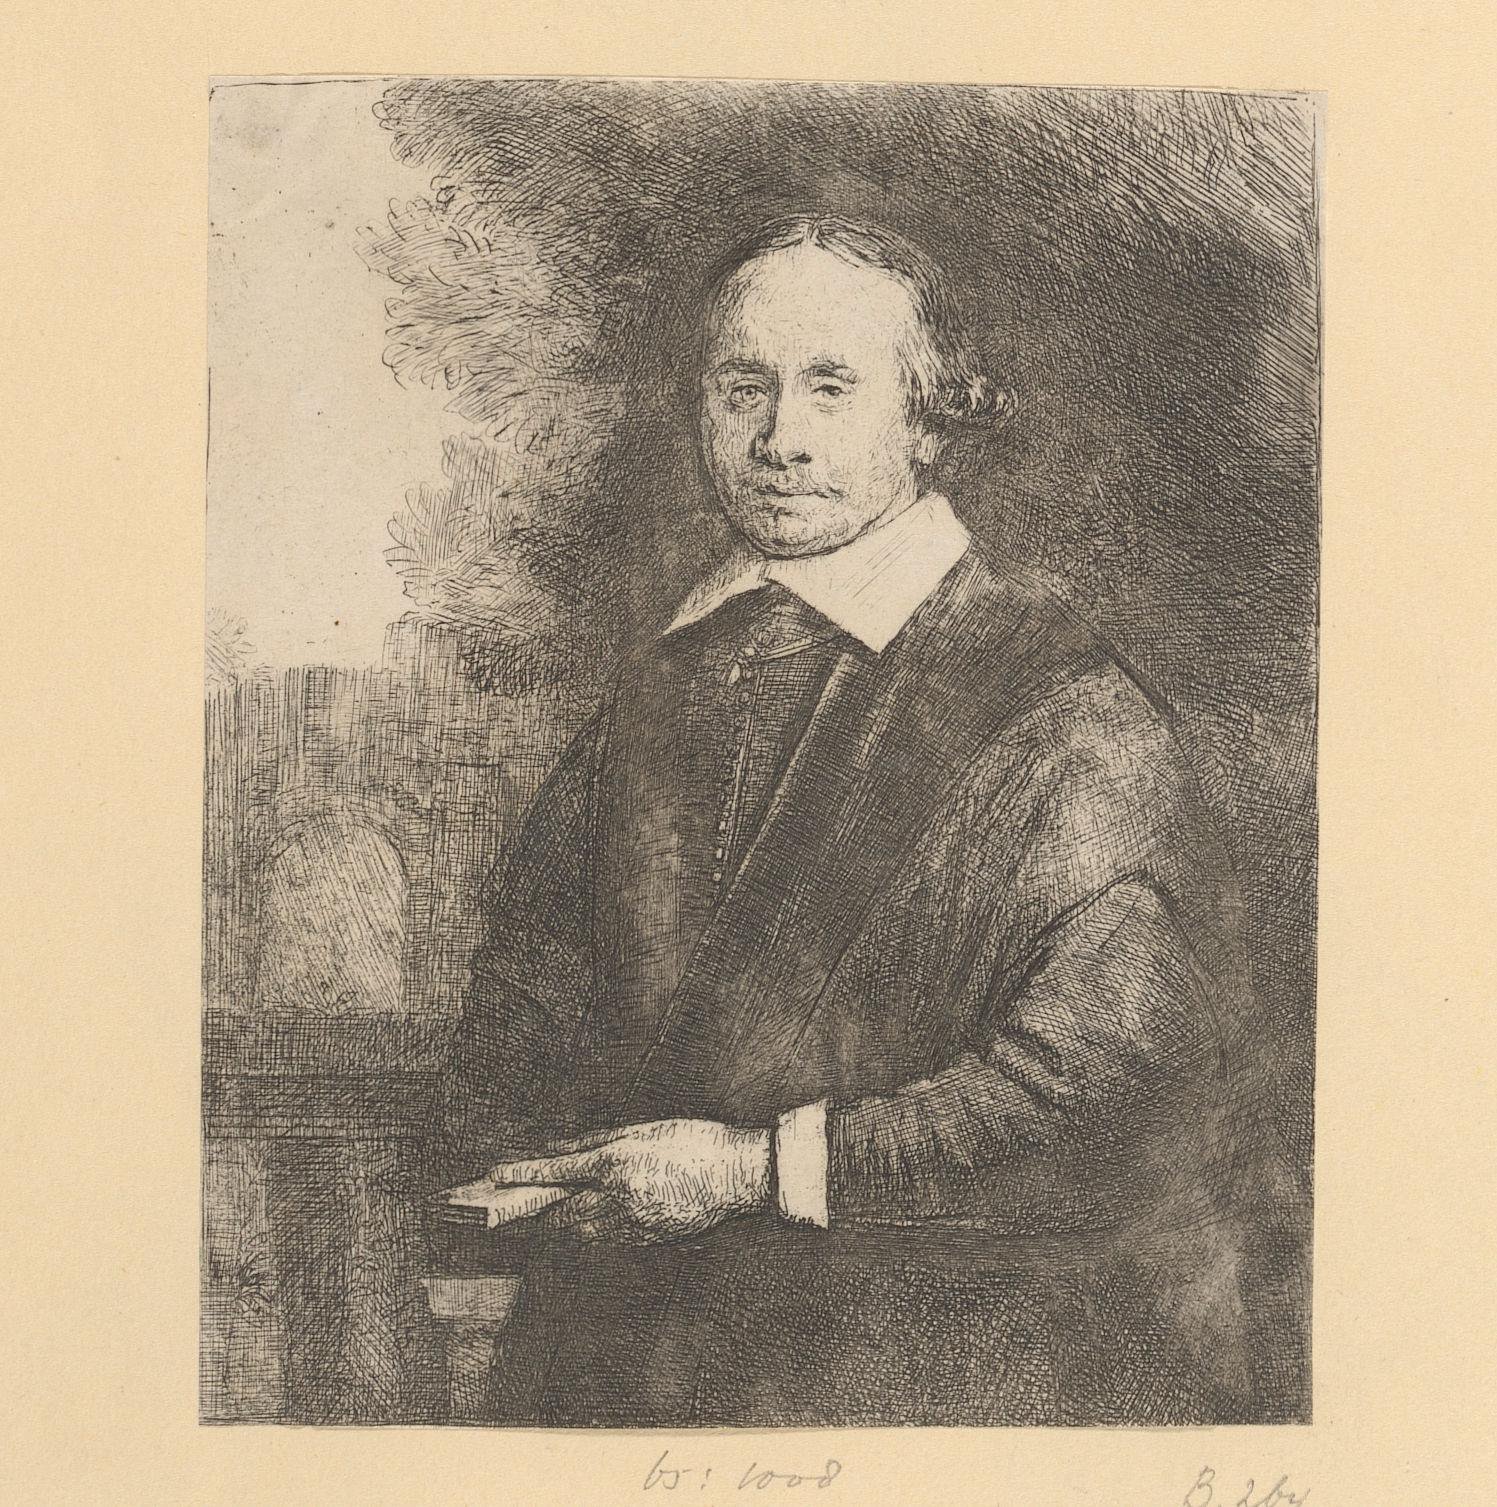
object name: album leaf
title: Jan Antonides van der Linden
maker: rembrandt van rijn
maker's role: draughtsman, painter, print maker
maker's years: 1606-1669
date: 1665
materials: paper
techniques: drypoint, etching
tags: jan antonides van der linden, botany (+ portrait of scholar, scientist), historical persons, portrait of a writer, physician, doctor (+ portrait of scholar, scientist)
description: Prent maakt mogelijk deel uit van een serie van 200 prenten. Deze serie is onder de titel 'A Collection of two hundred original etchings' voor het eerst uitgegeven door J.M. Greery in 1816.